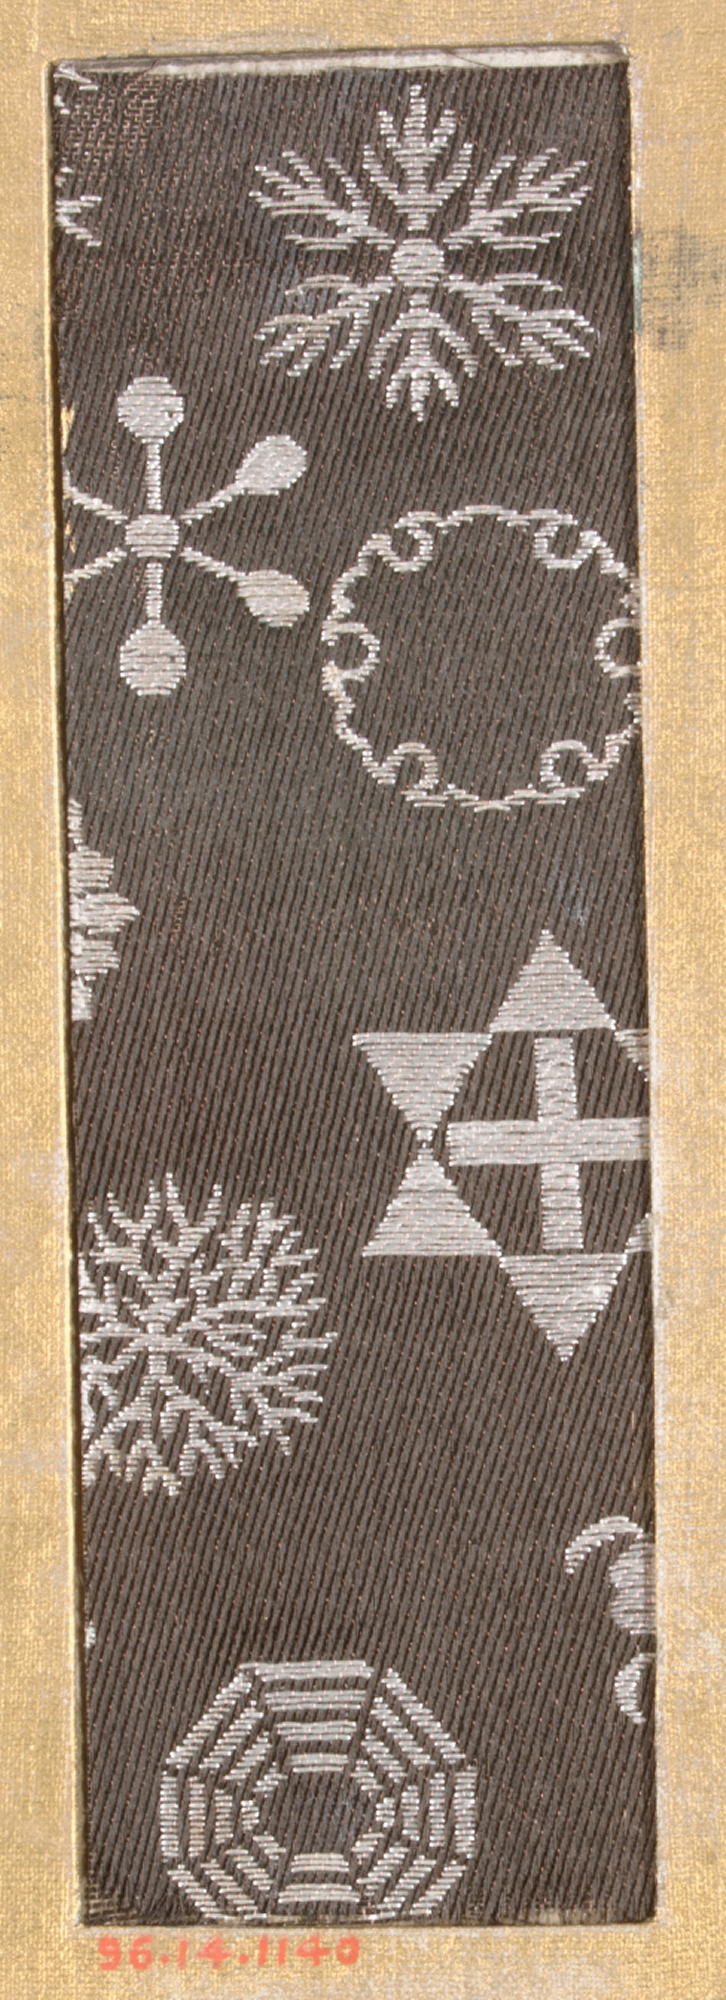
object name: piece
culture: japanese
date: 1701-1900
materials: silk